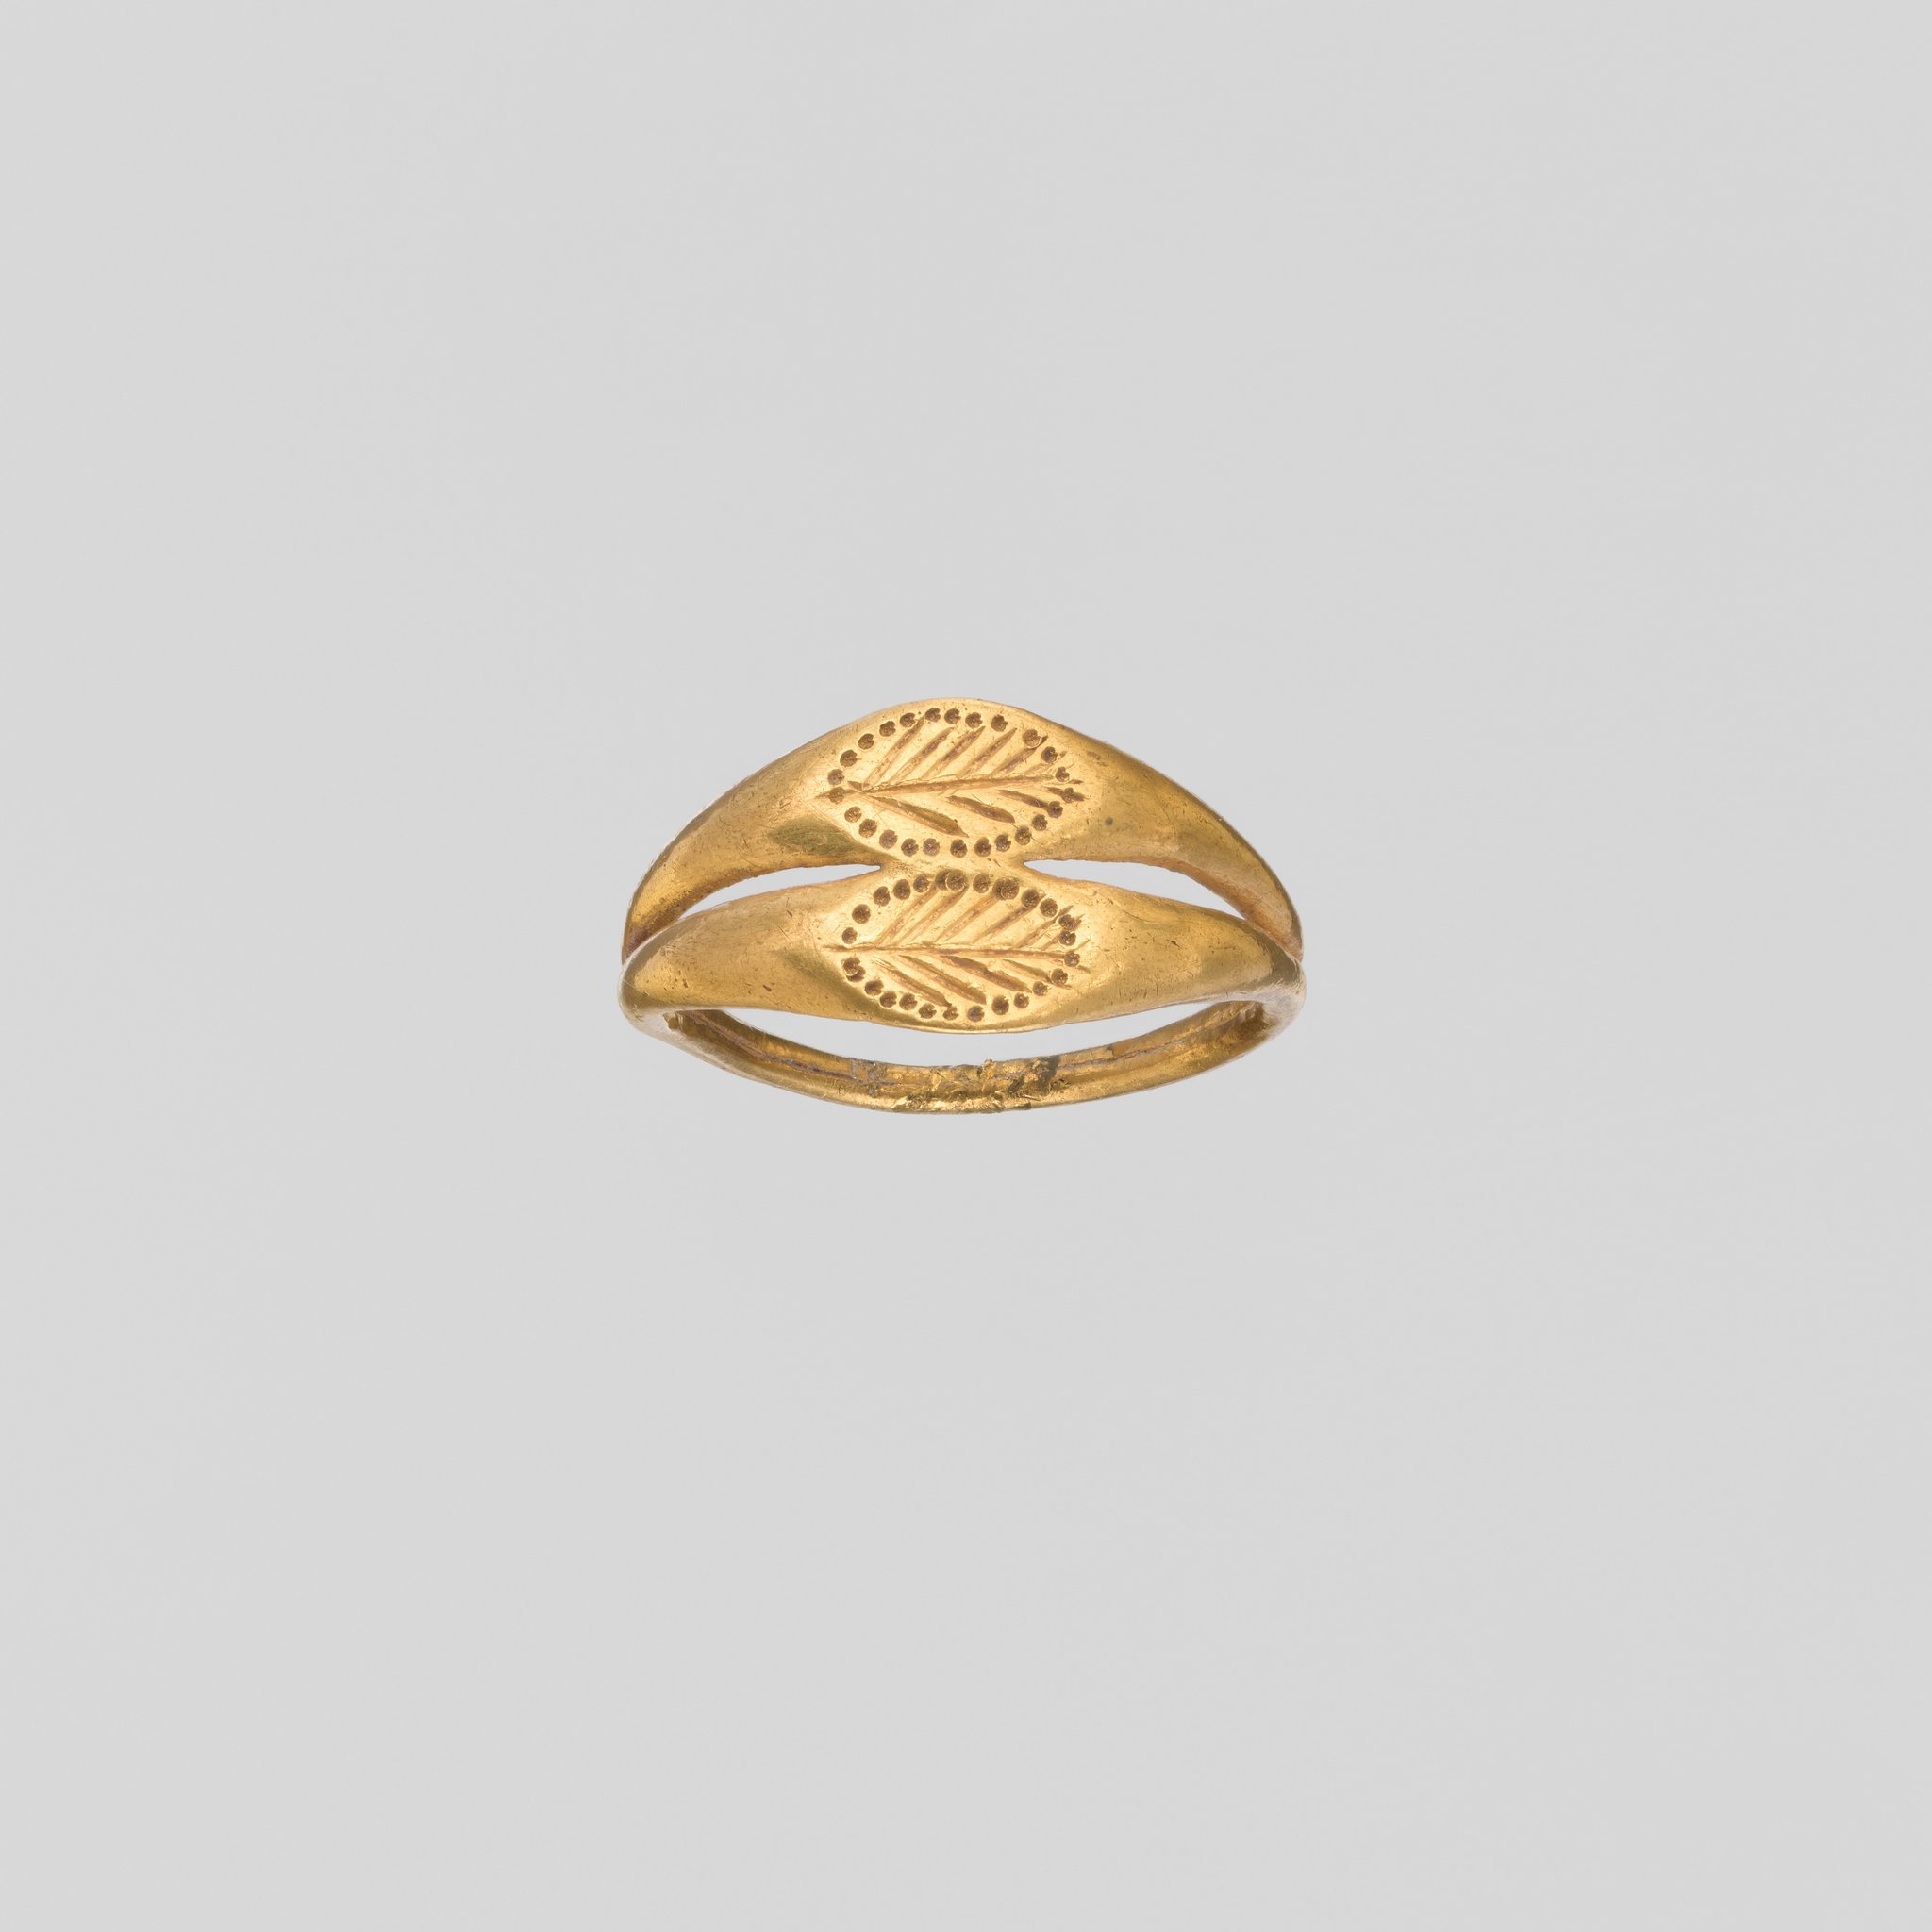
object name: ring, engraved with double bezel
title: Gold ring with a double hoop and a palm frond engraved on each bezel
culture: roman, cypriot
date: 1-200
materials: gold